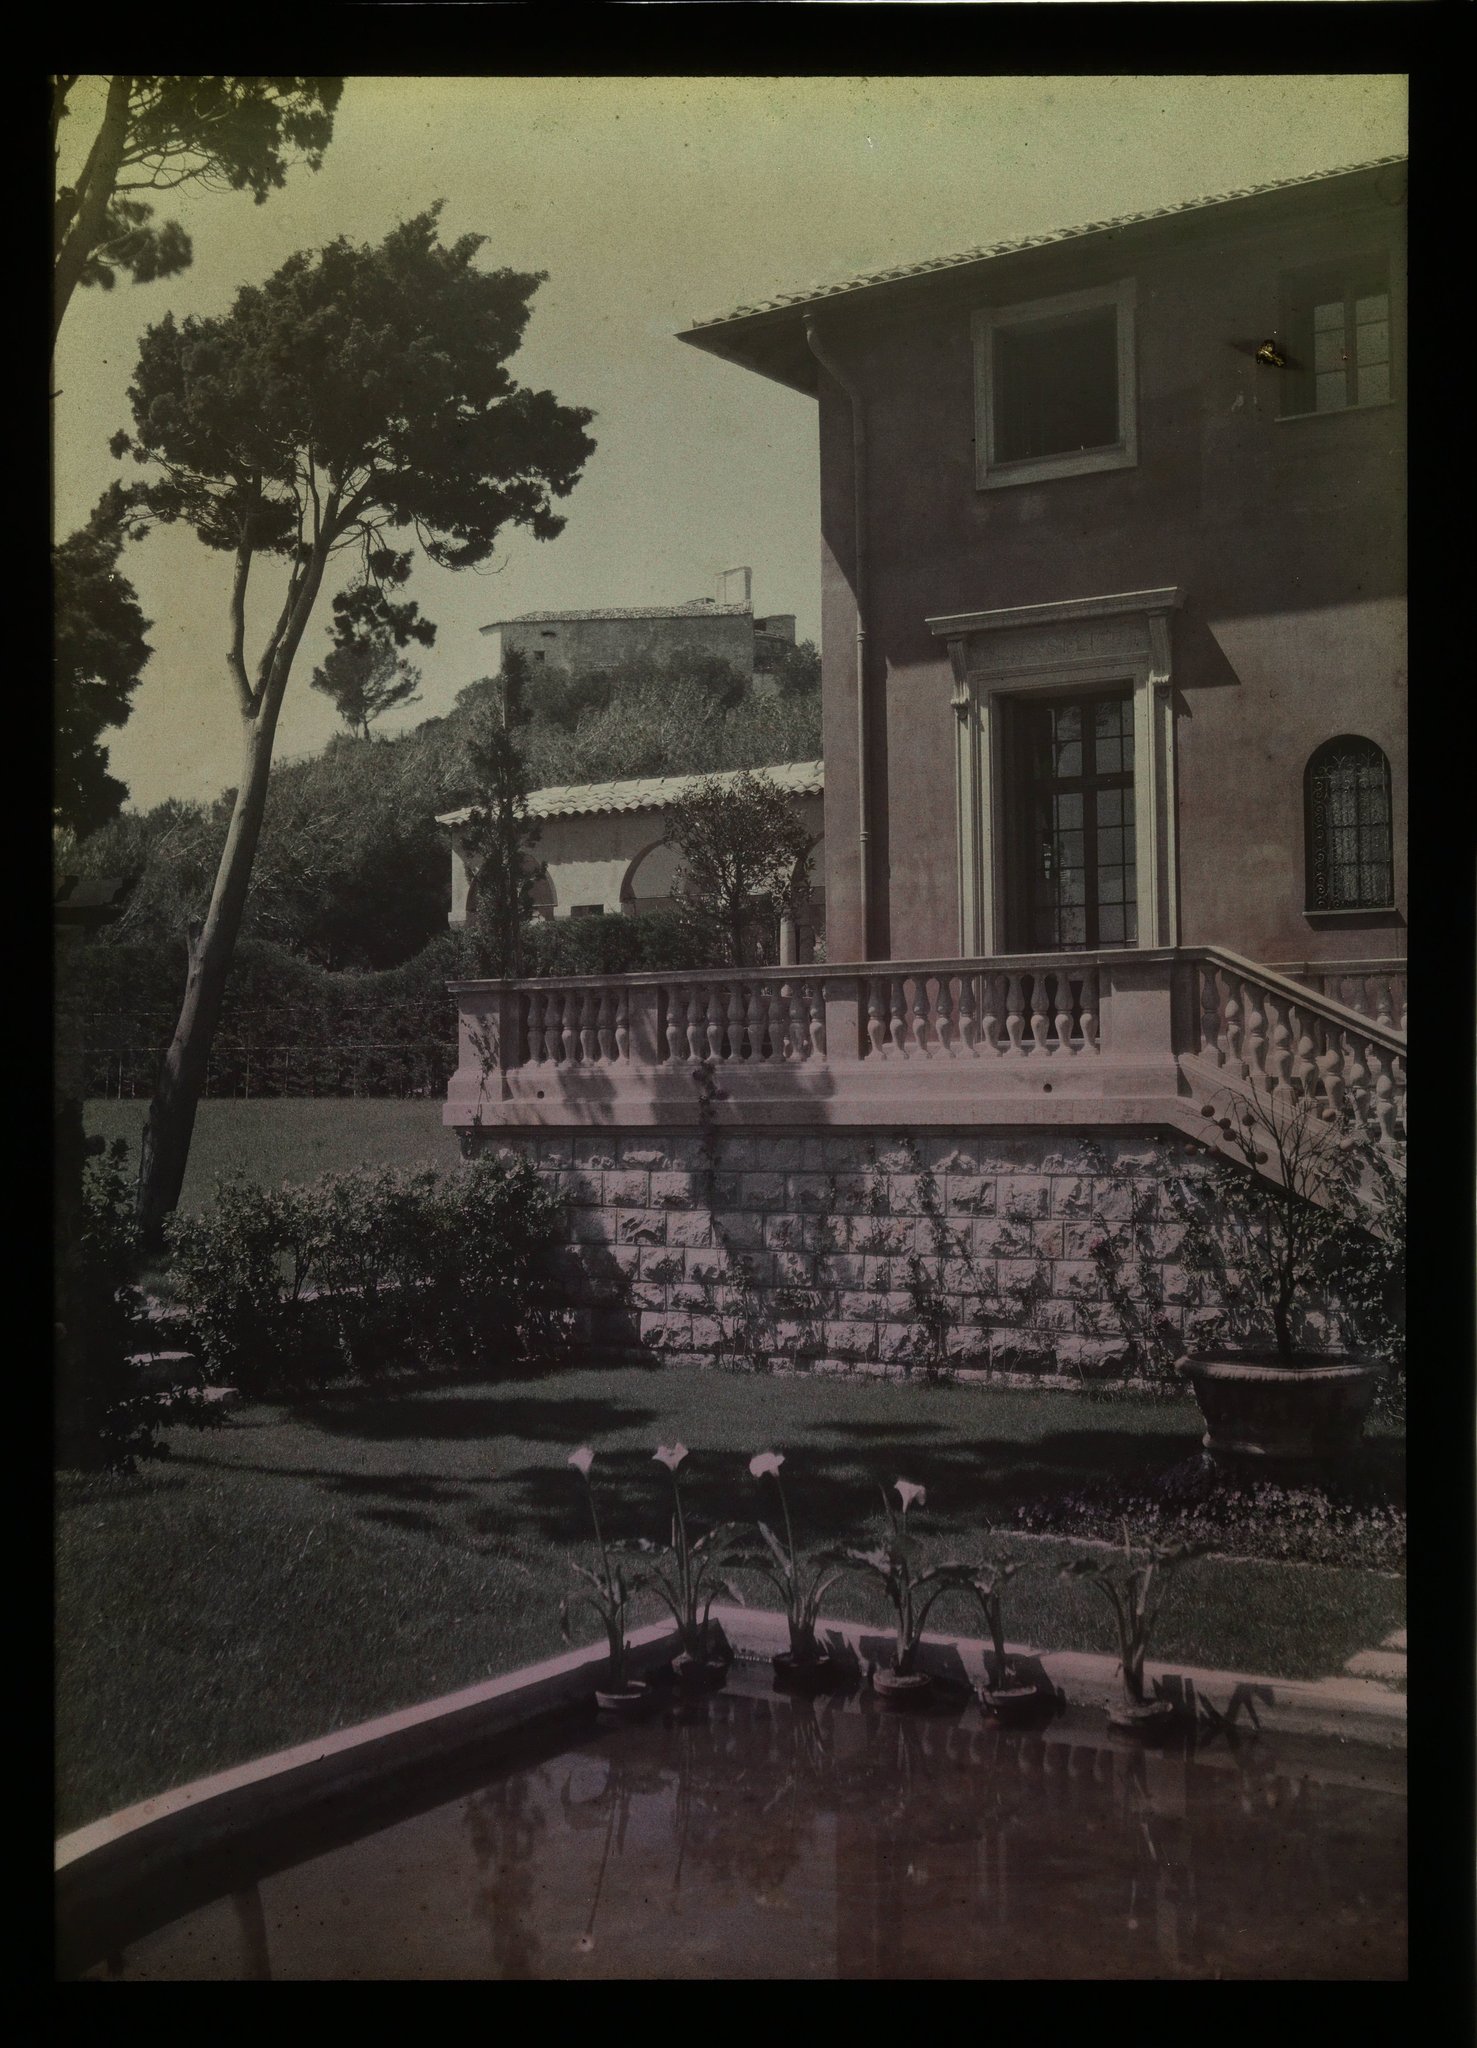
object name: photograph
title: Roze gepleisterd huis, met op de voorgrond een tuin met vijver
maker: Anonymous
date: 1910-1940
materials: glass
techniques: autochrome process